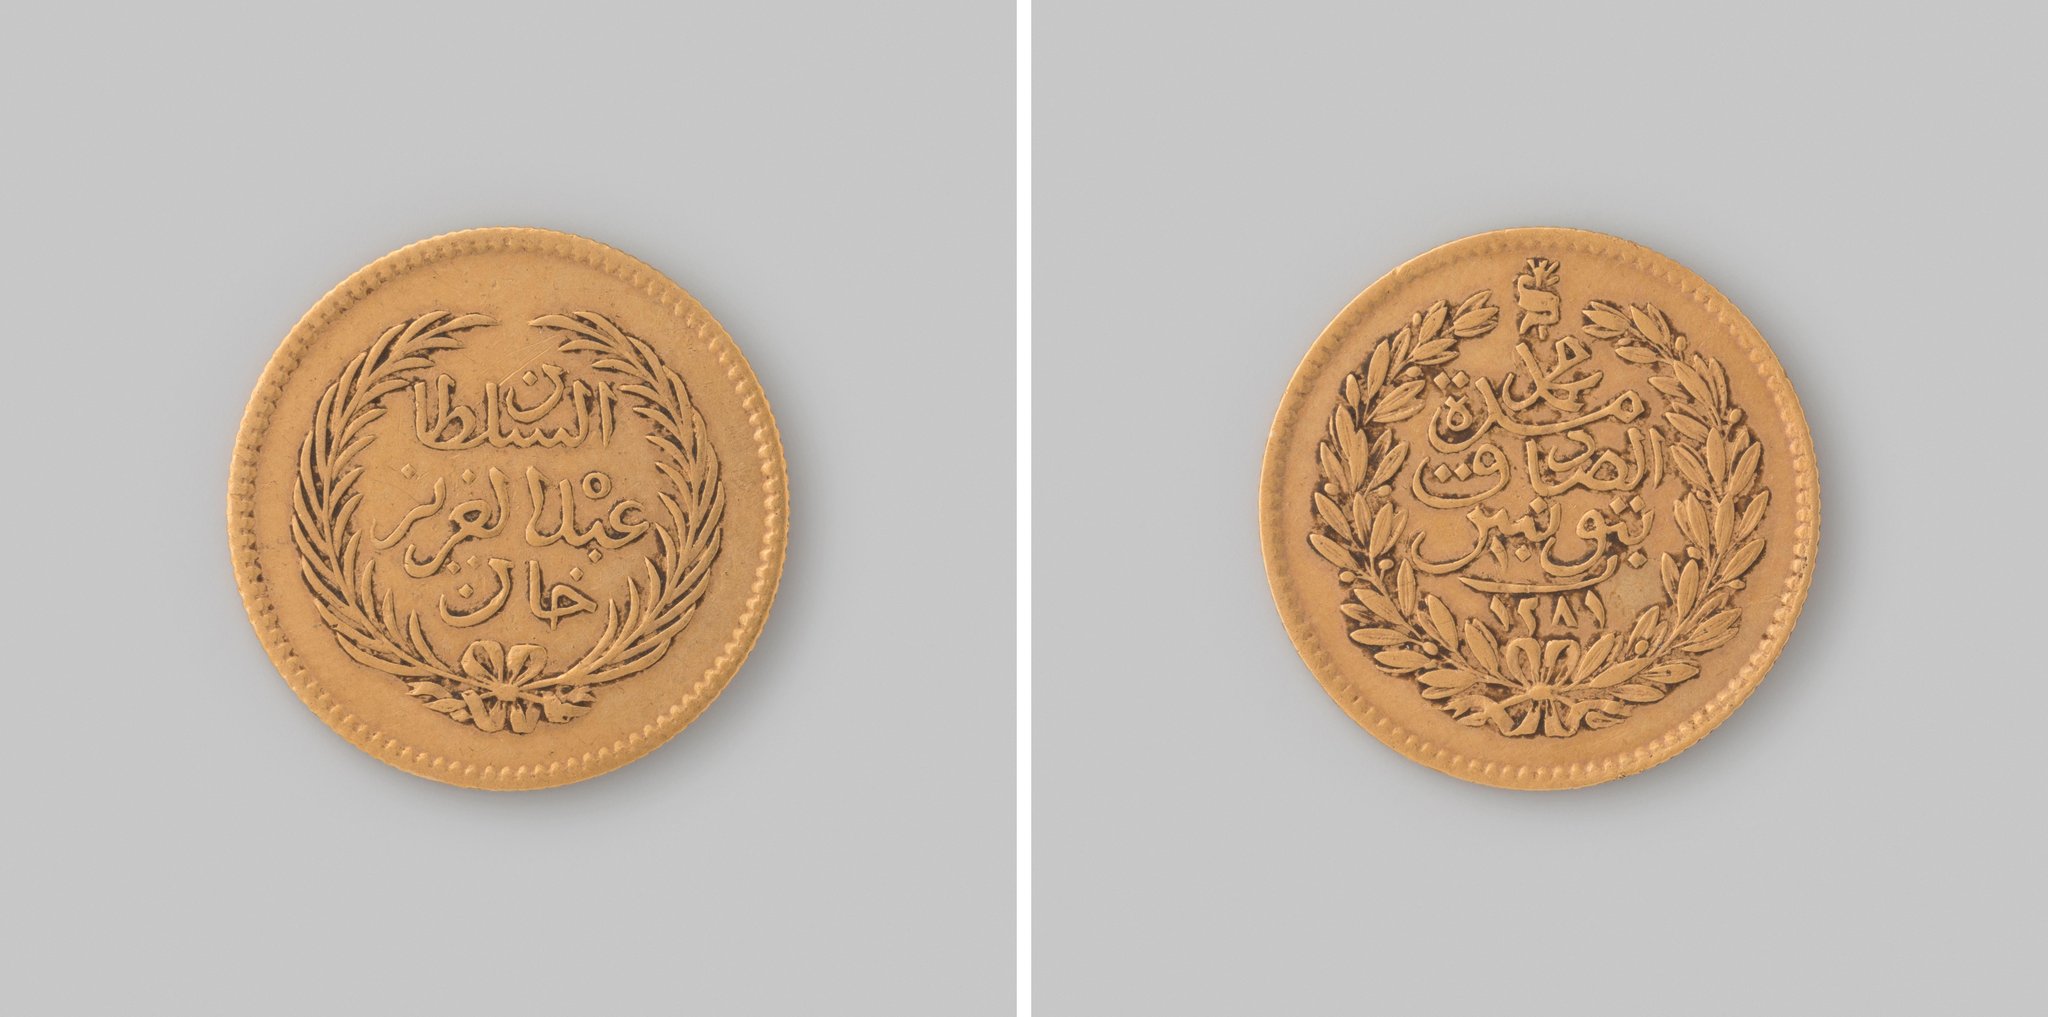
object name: tien piaster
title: Tunesië, 10 piastres, 1281 [=1864]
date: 1864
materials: gold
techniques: striking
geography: tunis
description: Gouden munt. Voorzijde: tussen twee samengebonden takken drieregelig opschrift in Arabische letters. Keerzijde: tussen twee samengebonden takken drieregelig opschrift in Arabische letters.Daaronder jaartal: 1281 [=1864]. Kabelrand.